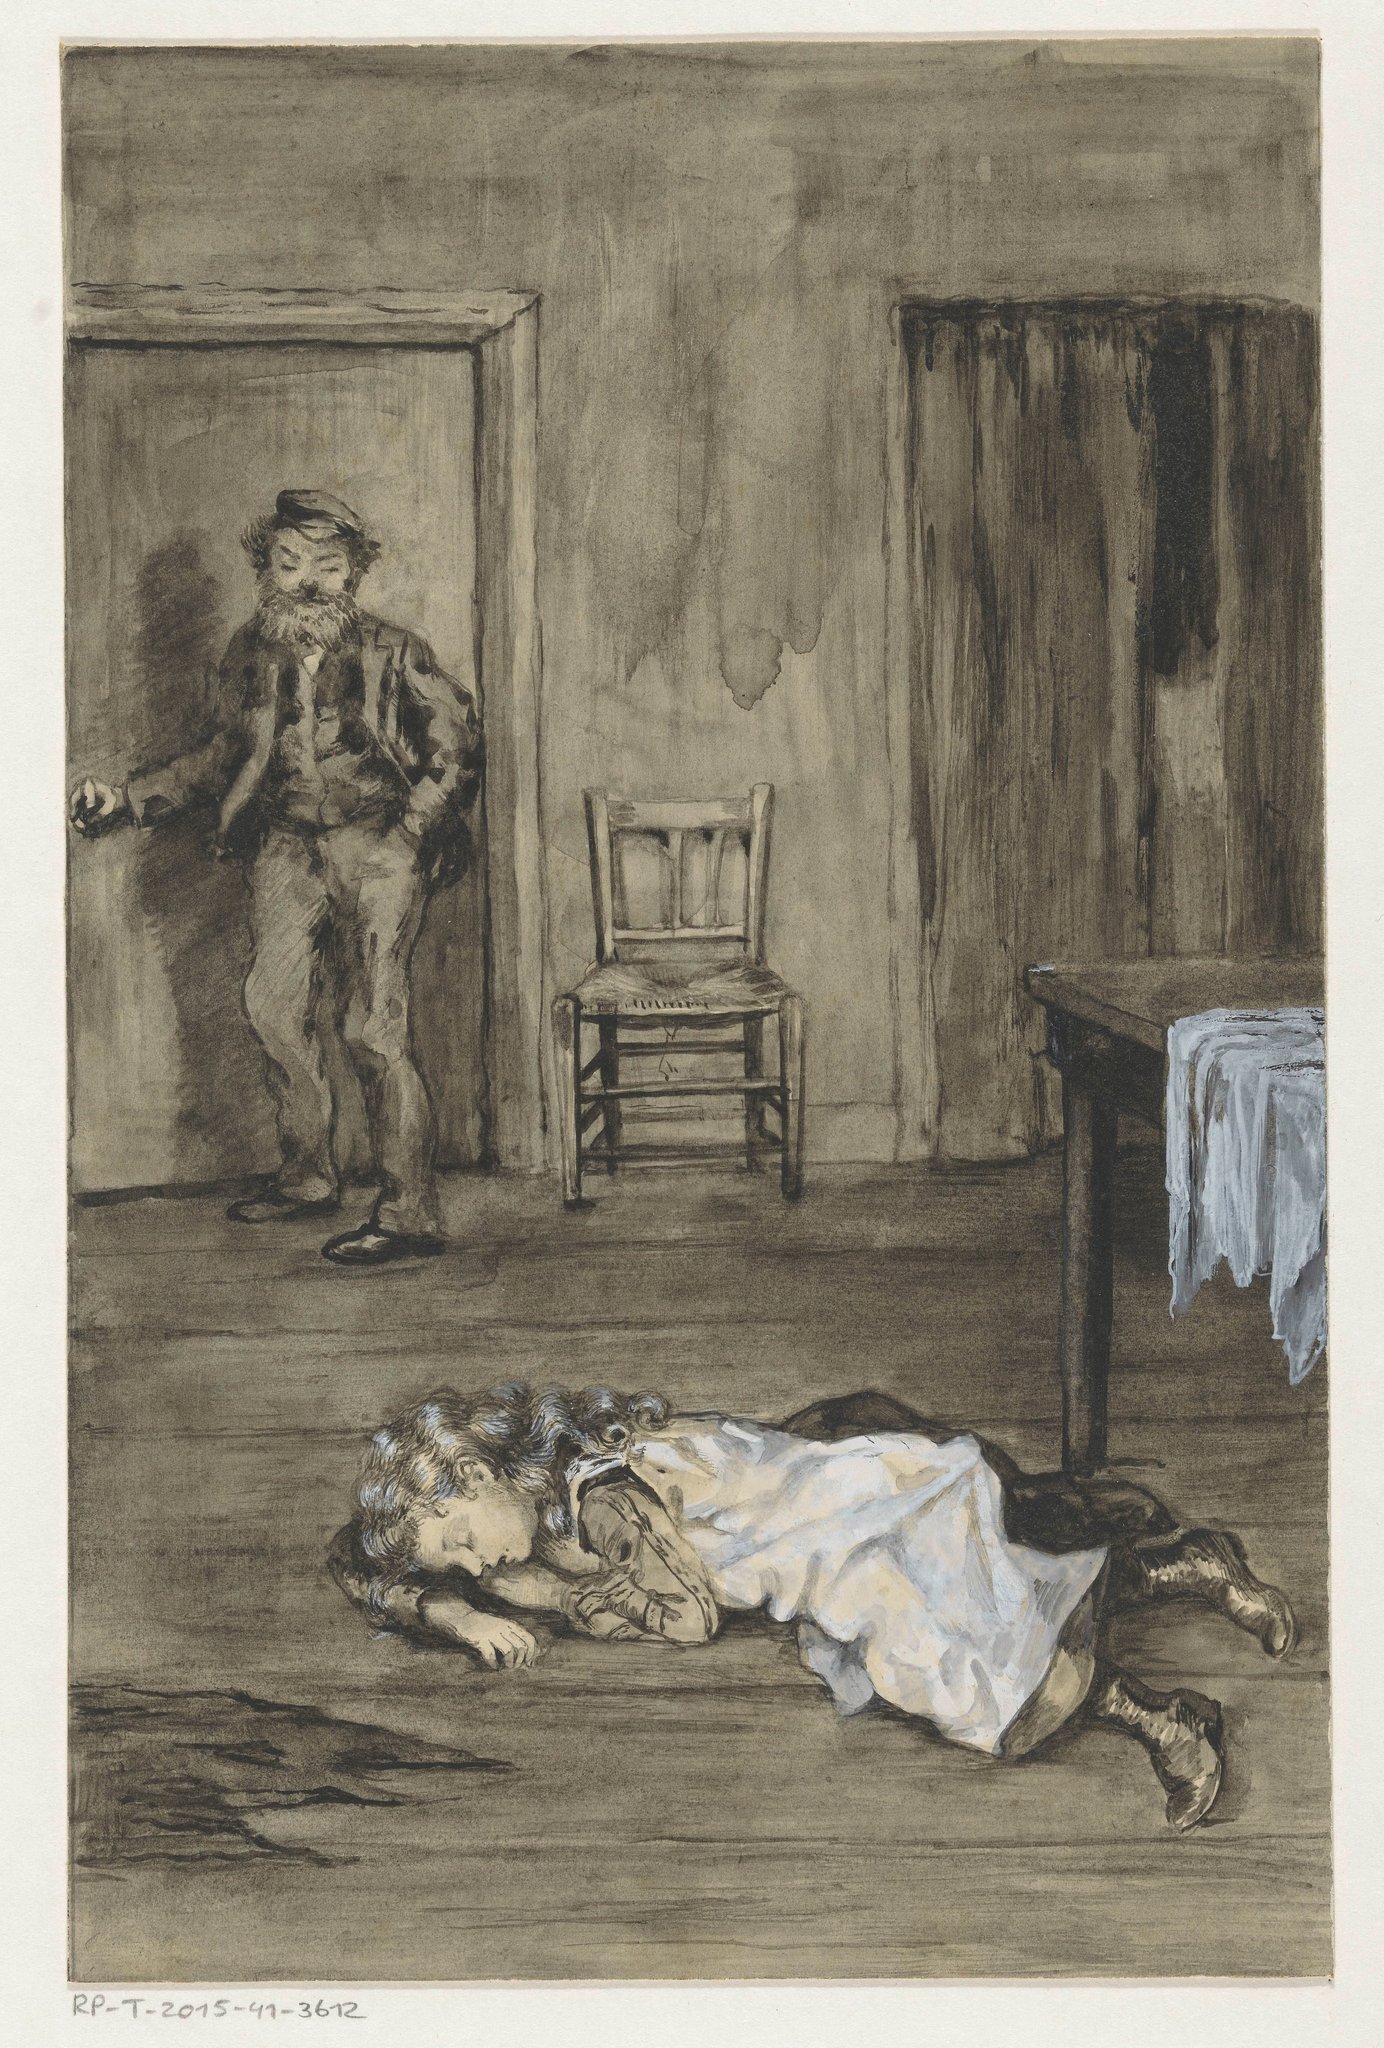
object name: boekillustratie ontwerp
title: Slapend meisje op een vloer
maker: anna maria kruijff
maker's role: draughtsman, print maker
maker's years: 1870-1946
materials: paint, paper, pencil, watercolor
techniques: brush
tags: sleeping on the ground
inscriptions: collector's mark: Lugt 2228a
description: Een meisje gekleed in een jurk met schort ligt op de houten vloer van een kamer te slapen. In de achtergrond staat een man met een baard bij de deur.